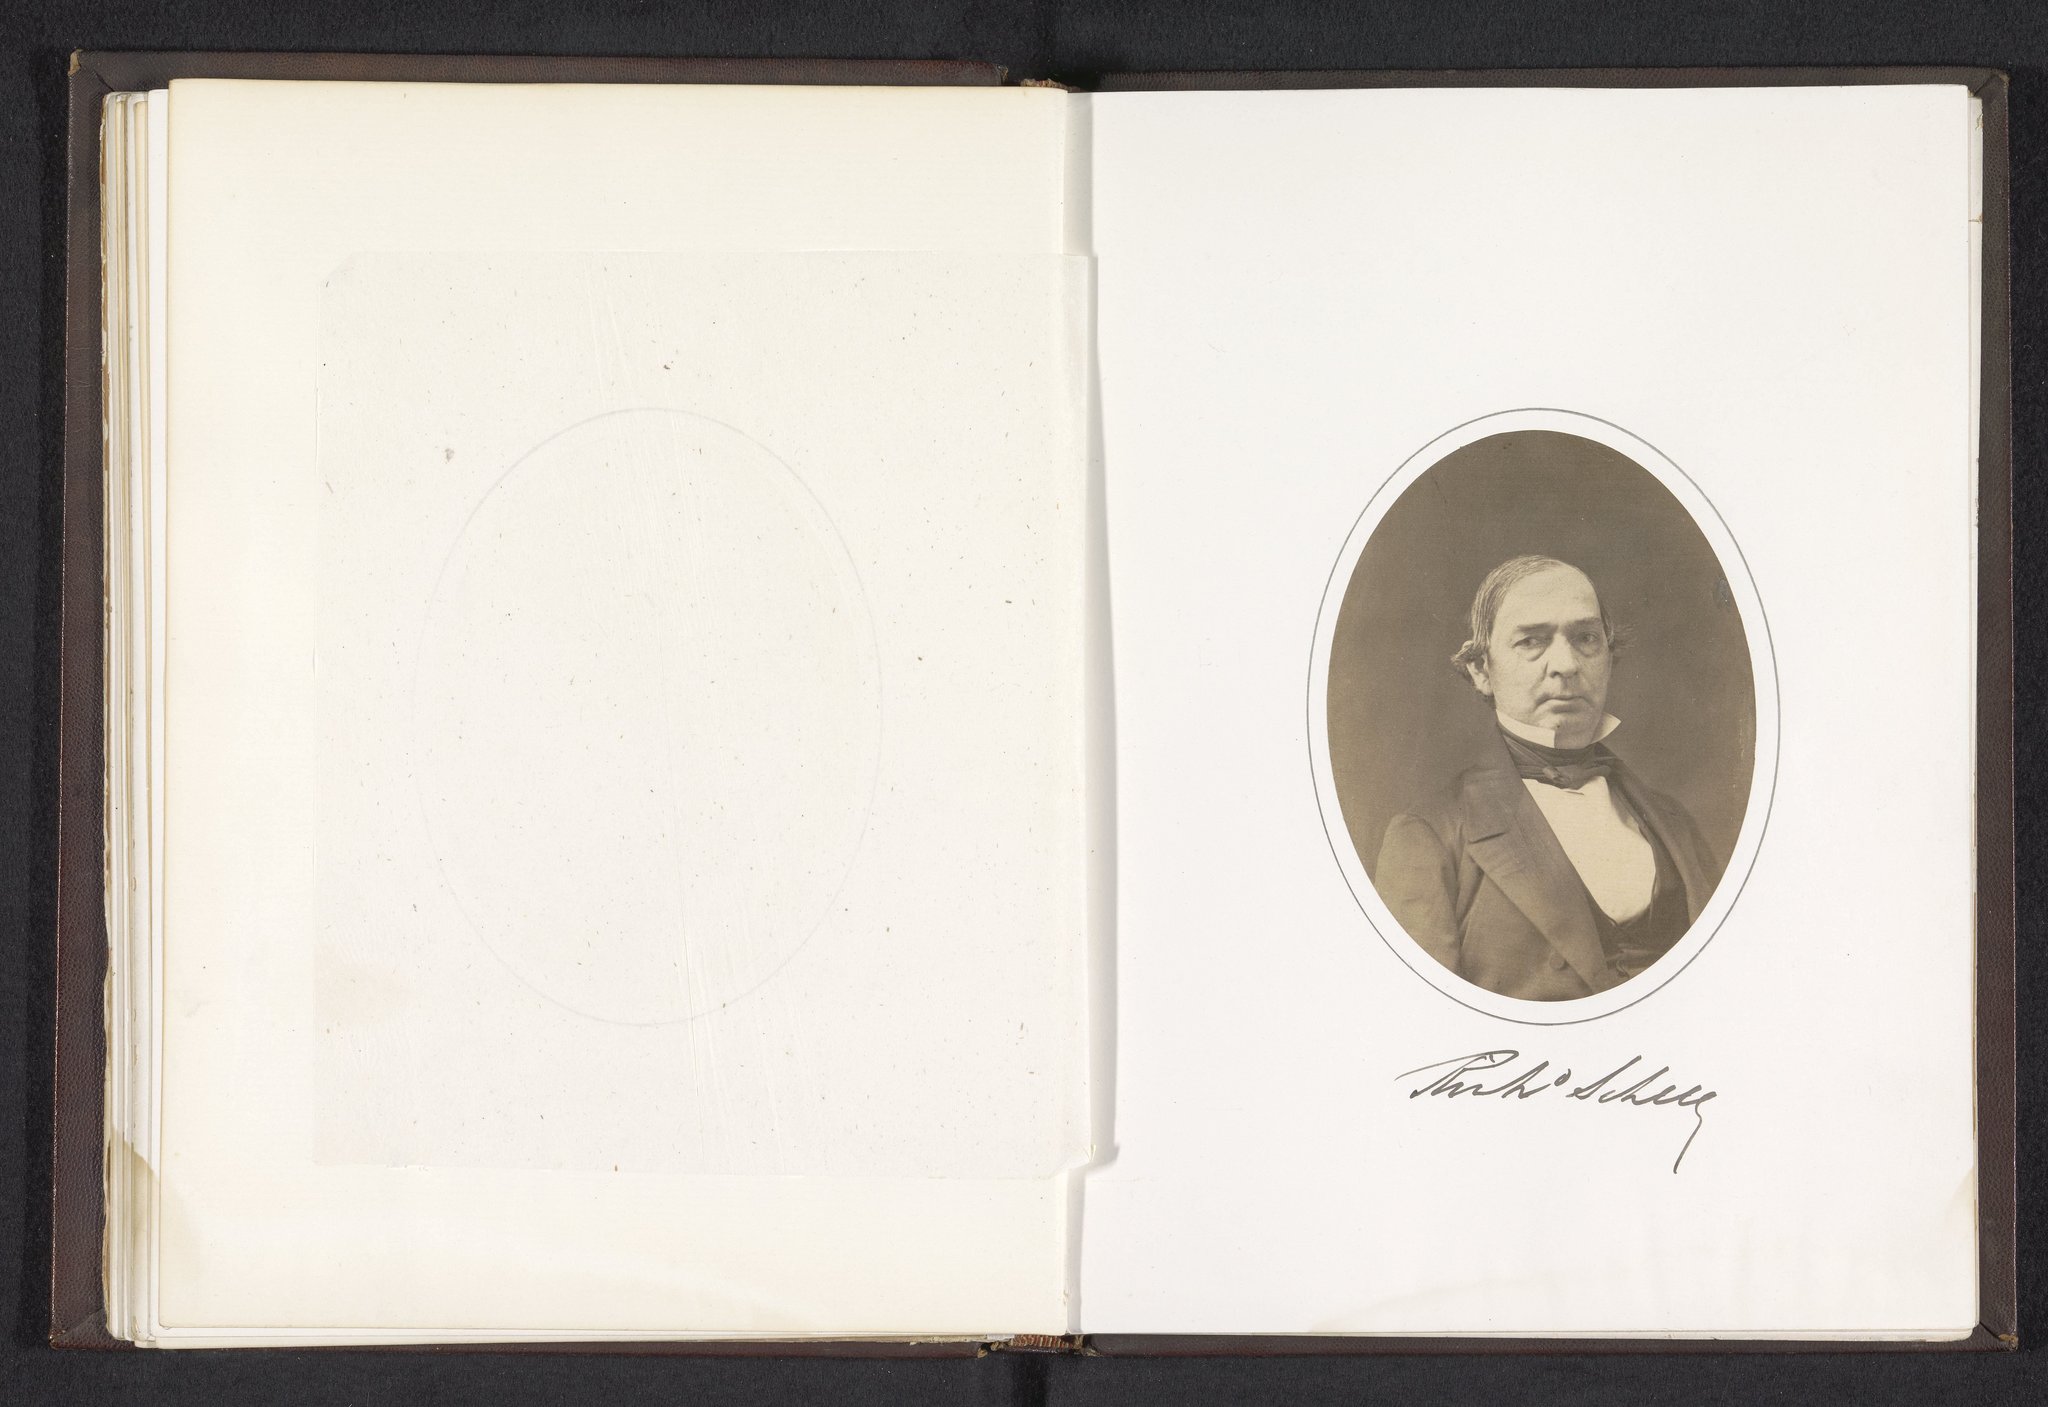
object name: page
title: Portret van Senaatslid Richard Schell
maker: d.t.t. davie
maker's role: publisher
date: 1858-1859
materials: photographic support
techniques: salted paper print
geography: new york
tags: politician, politician, e.g. party leader, upper house, senate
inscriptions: inscription: ‘Richd Schell’